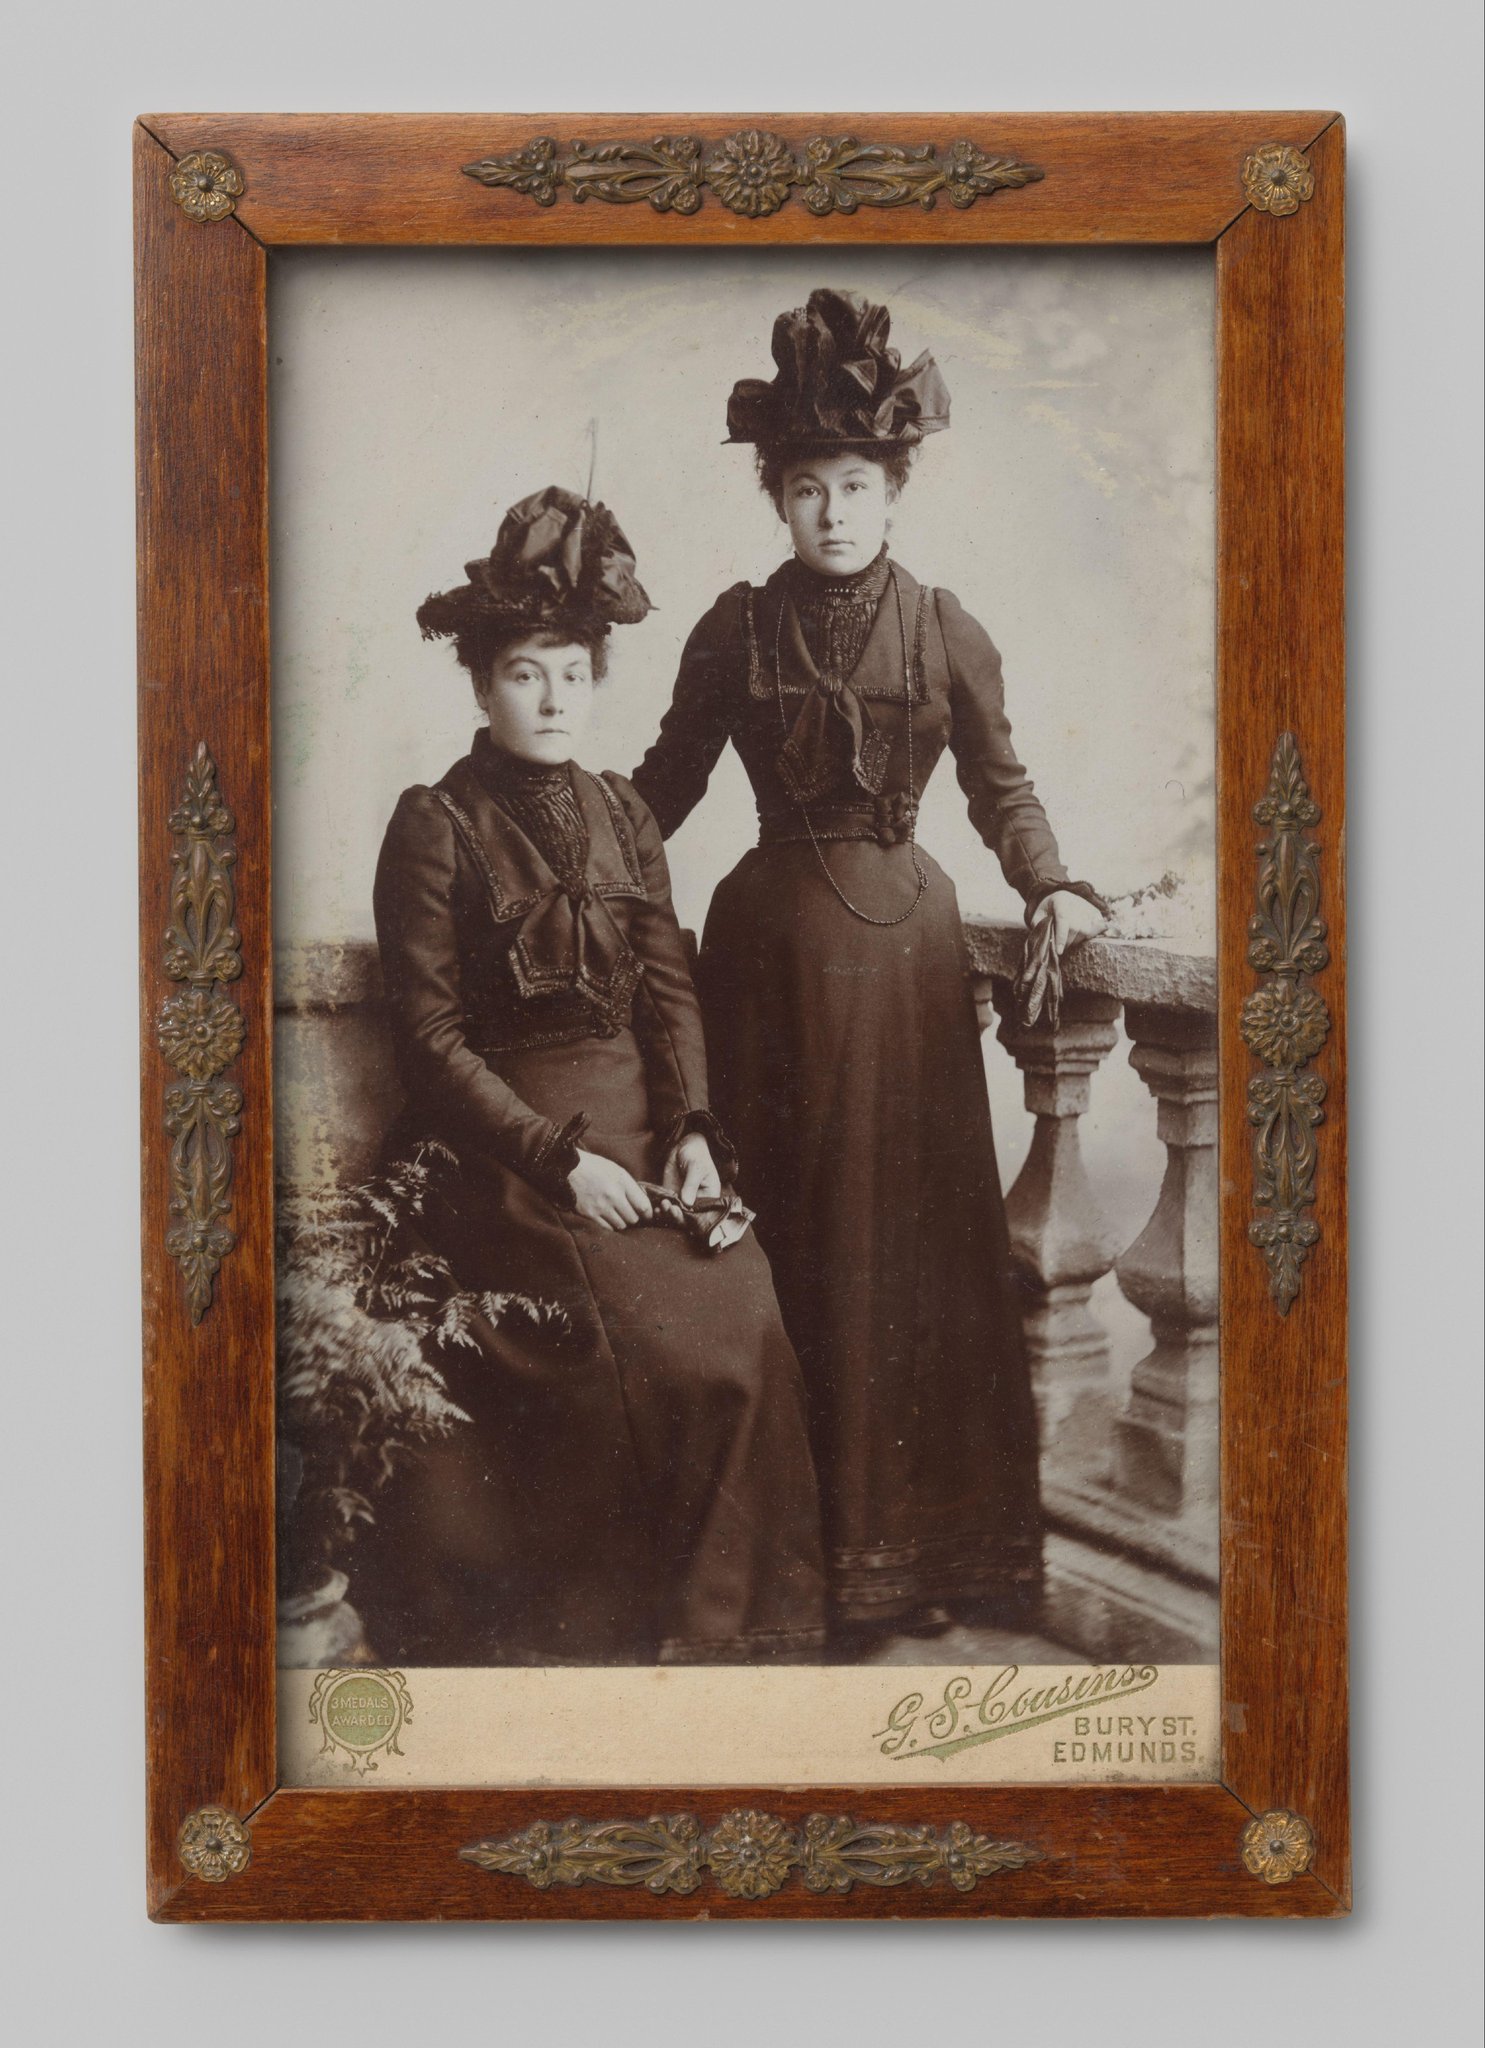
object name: photograph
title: Portret van twee onbekende vrouwen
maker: george sebastian cousins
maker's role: fotograaf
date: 1880-1910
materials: paper, cardboard, glass, metal, fiber, wood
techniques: gelatin silver print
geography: st edmundsbury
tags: anonymous historical person portrayed - bb - woman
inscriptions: inscription: ‘3MEDALS/ AWARDED/ G.S. Cousins/ BURY ST./ EDMUNDS’